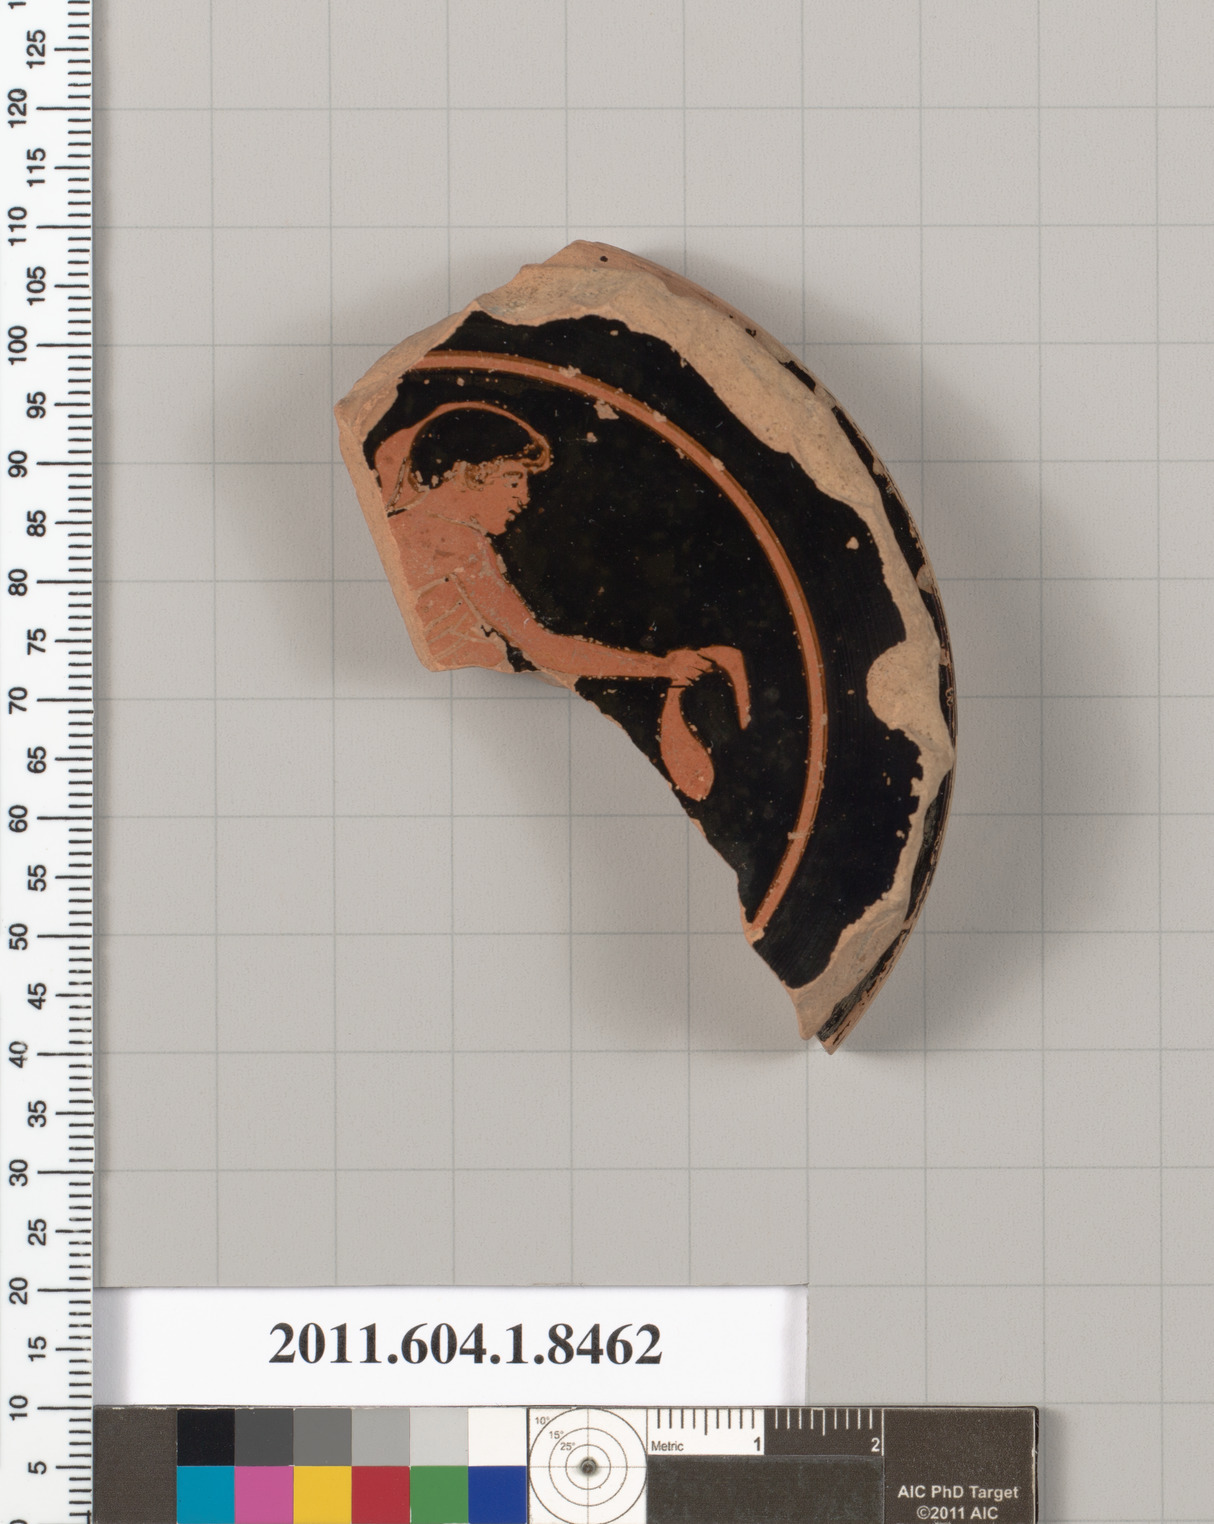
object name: kylix fragment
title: Terracotta fragment of a stemless kylix (drinking cup)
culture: greek, attic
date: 475-451 BCE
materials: terracotta